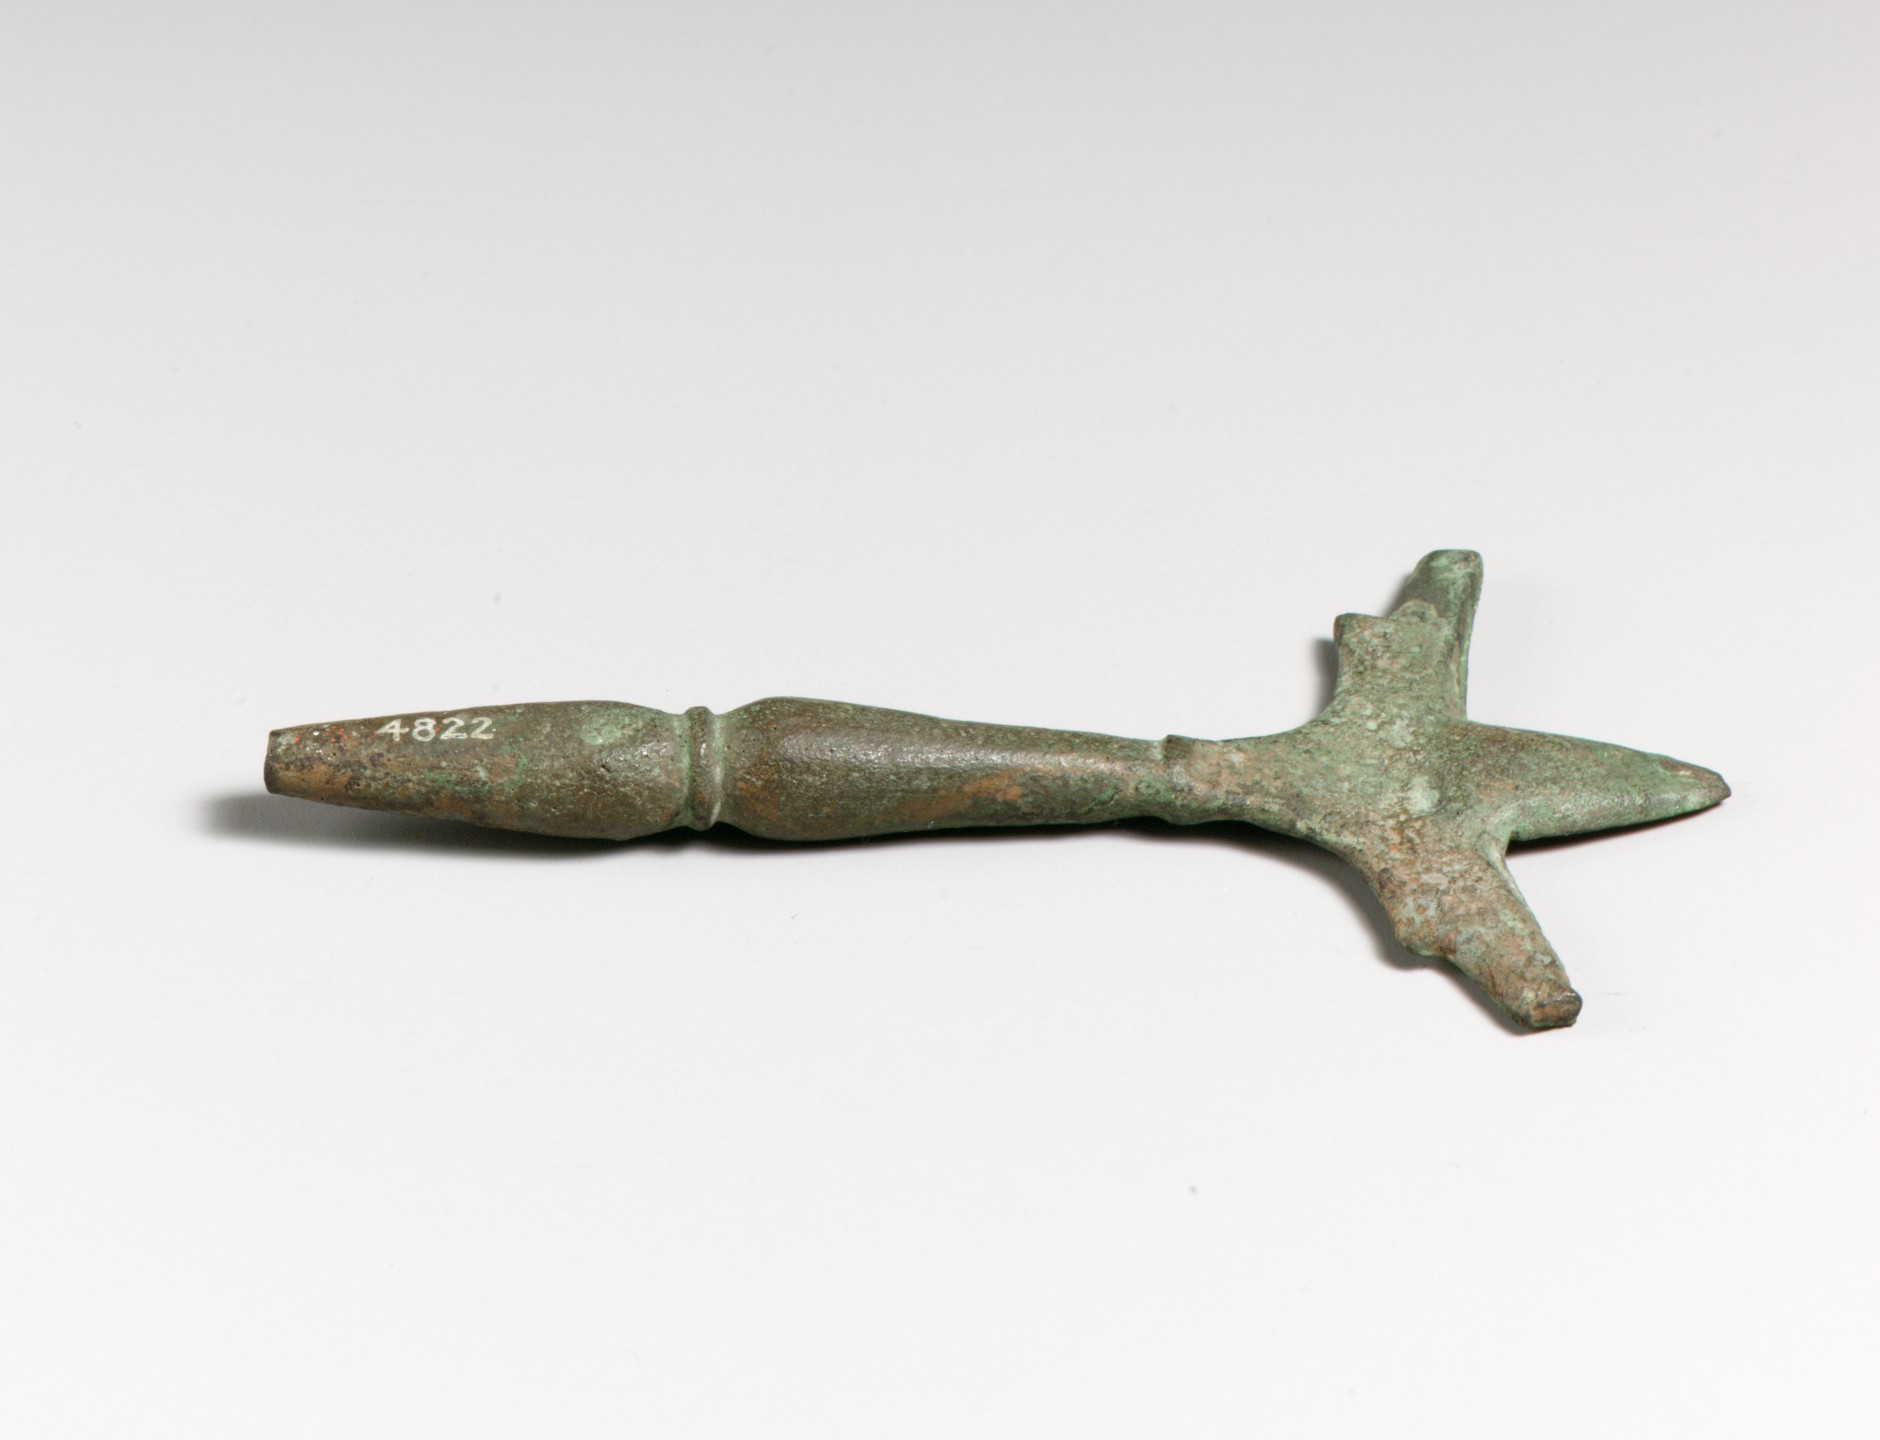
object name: mirror handle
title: Handle of a mirror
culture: roman, cypriot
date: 50-400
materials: bronze